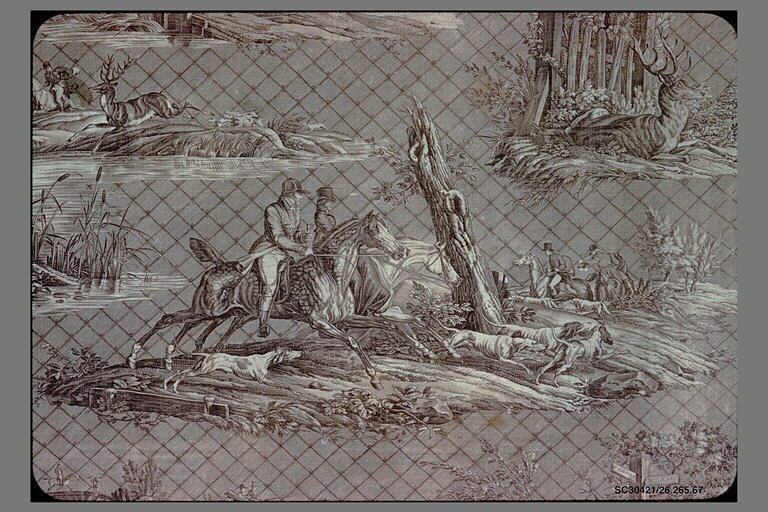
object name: furnishing textile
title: Route to Jouy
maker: oberkampf manufactory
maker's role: manufactory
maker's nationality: french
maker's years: 1760-1843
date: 1815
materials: cotton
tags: fences,men,hunting,deer,dogs,horses,trees